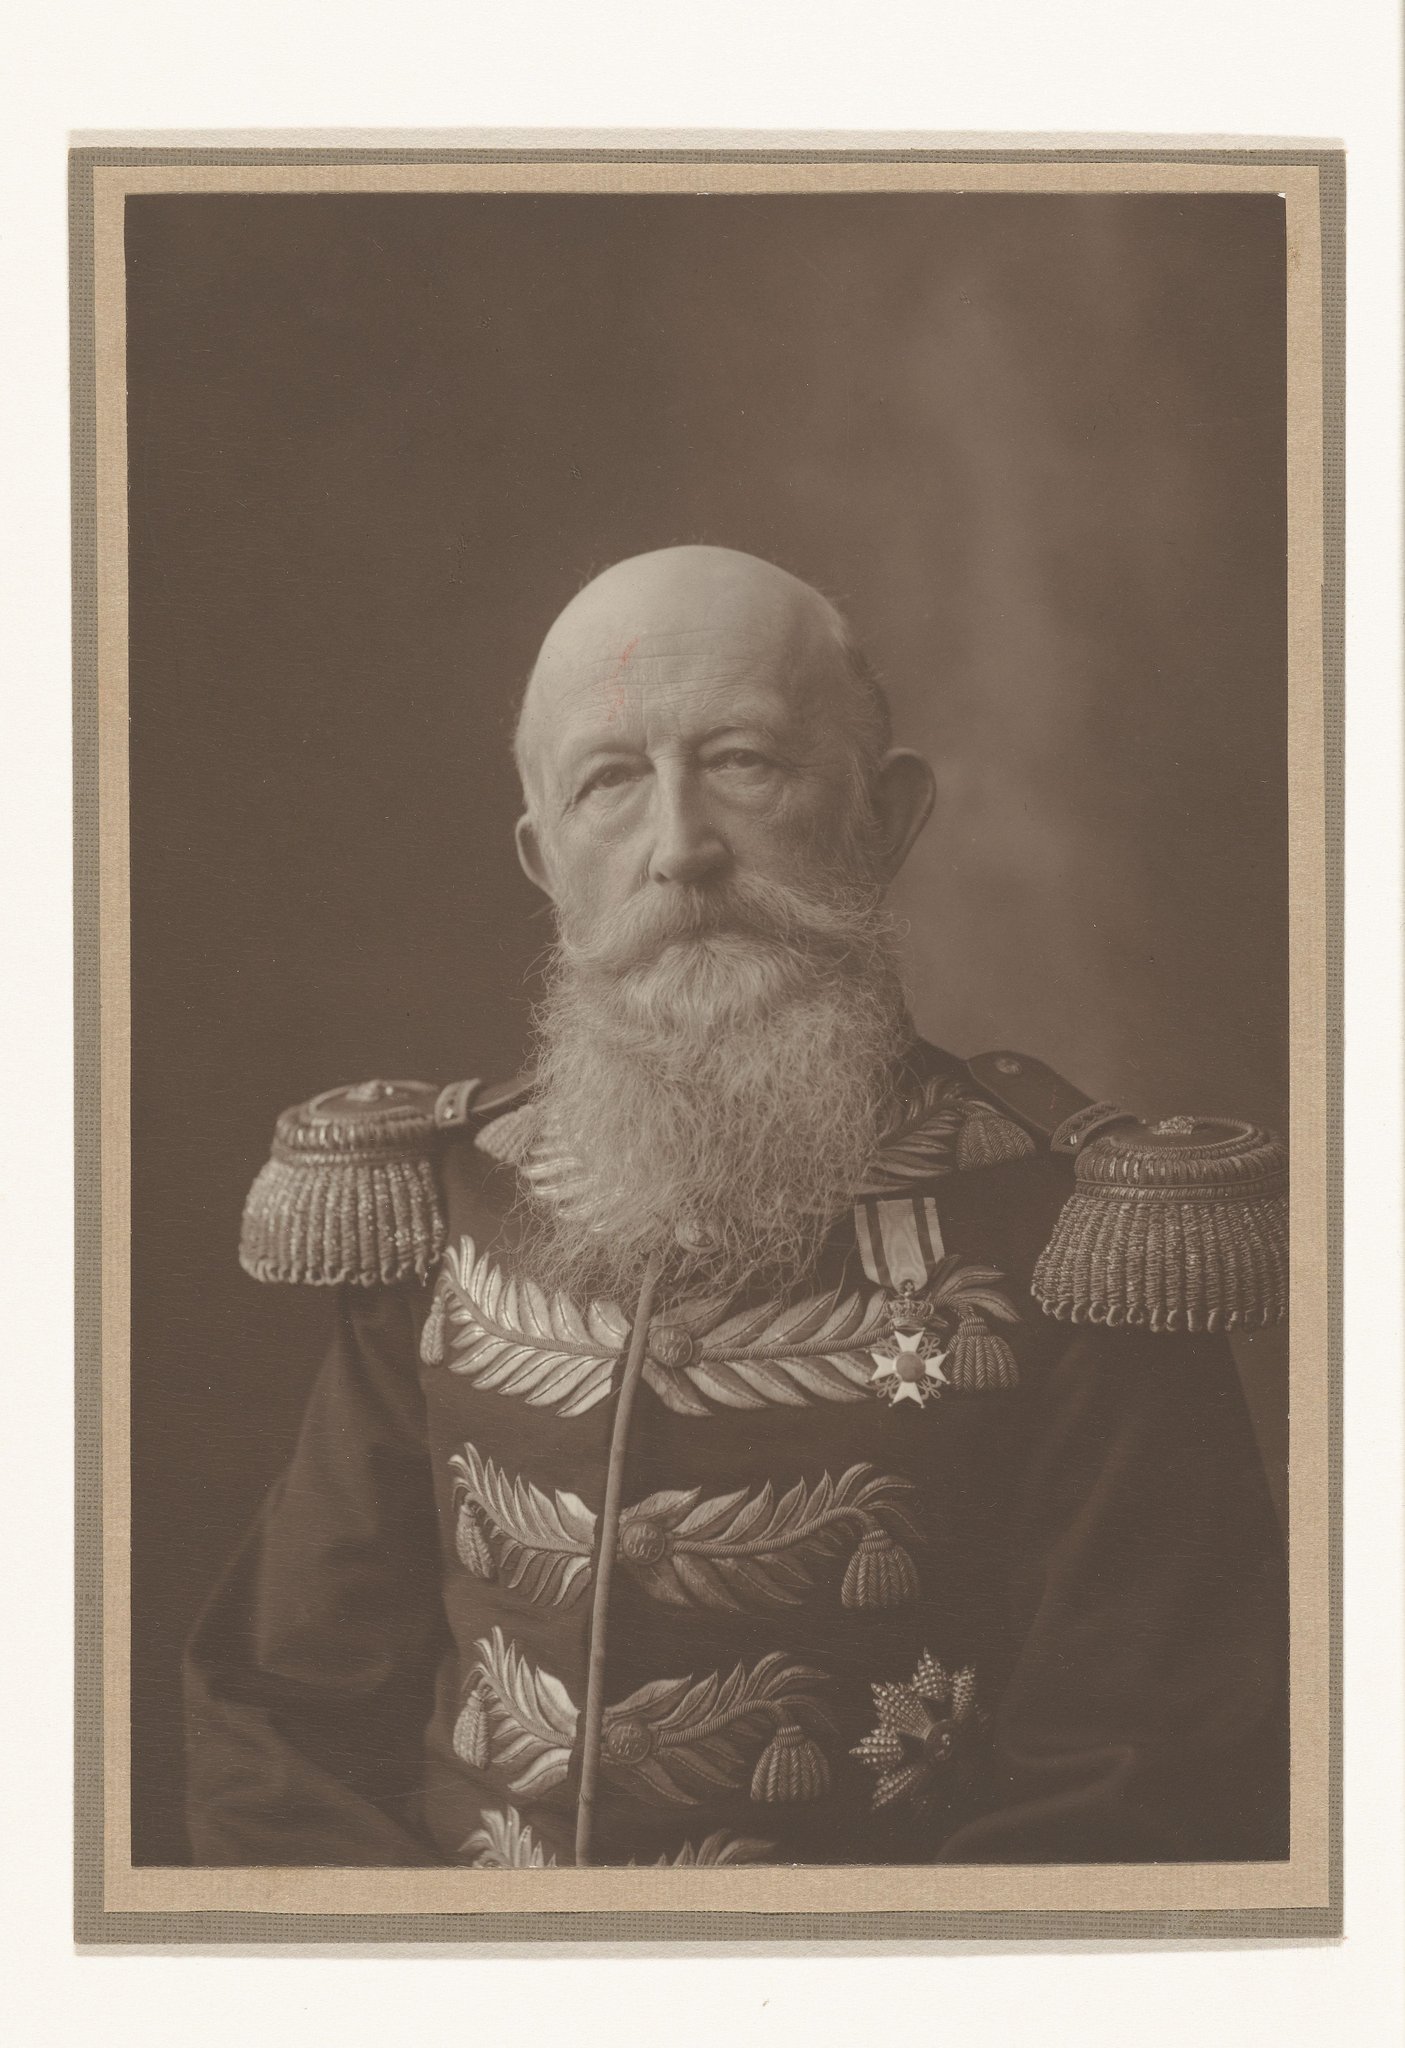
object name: photograph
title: Portret van jhr. Henricus Paulus Cornelis Bosch van Drakestein, lid van de Eerste Kamer en kamerheer in buitengewone dienst van koningin Wilhelmina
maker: francis kramer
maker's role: fotograaf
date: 1900-1914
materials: cardboard, paper, photographic support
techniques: carbon print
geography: utrecht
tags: the hague, print maker, wilhelmina of the netherlands, mayor, burgomaster, historical persons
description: Identificatie op basis van portret in Iconografisch Bureau.